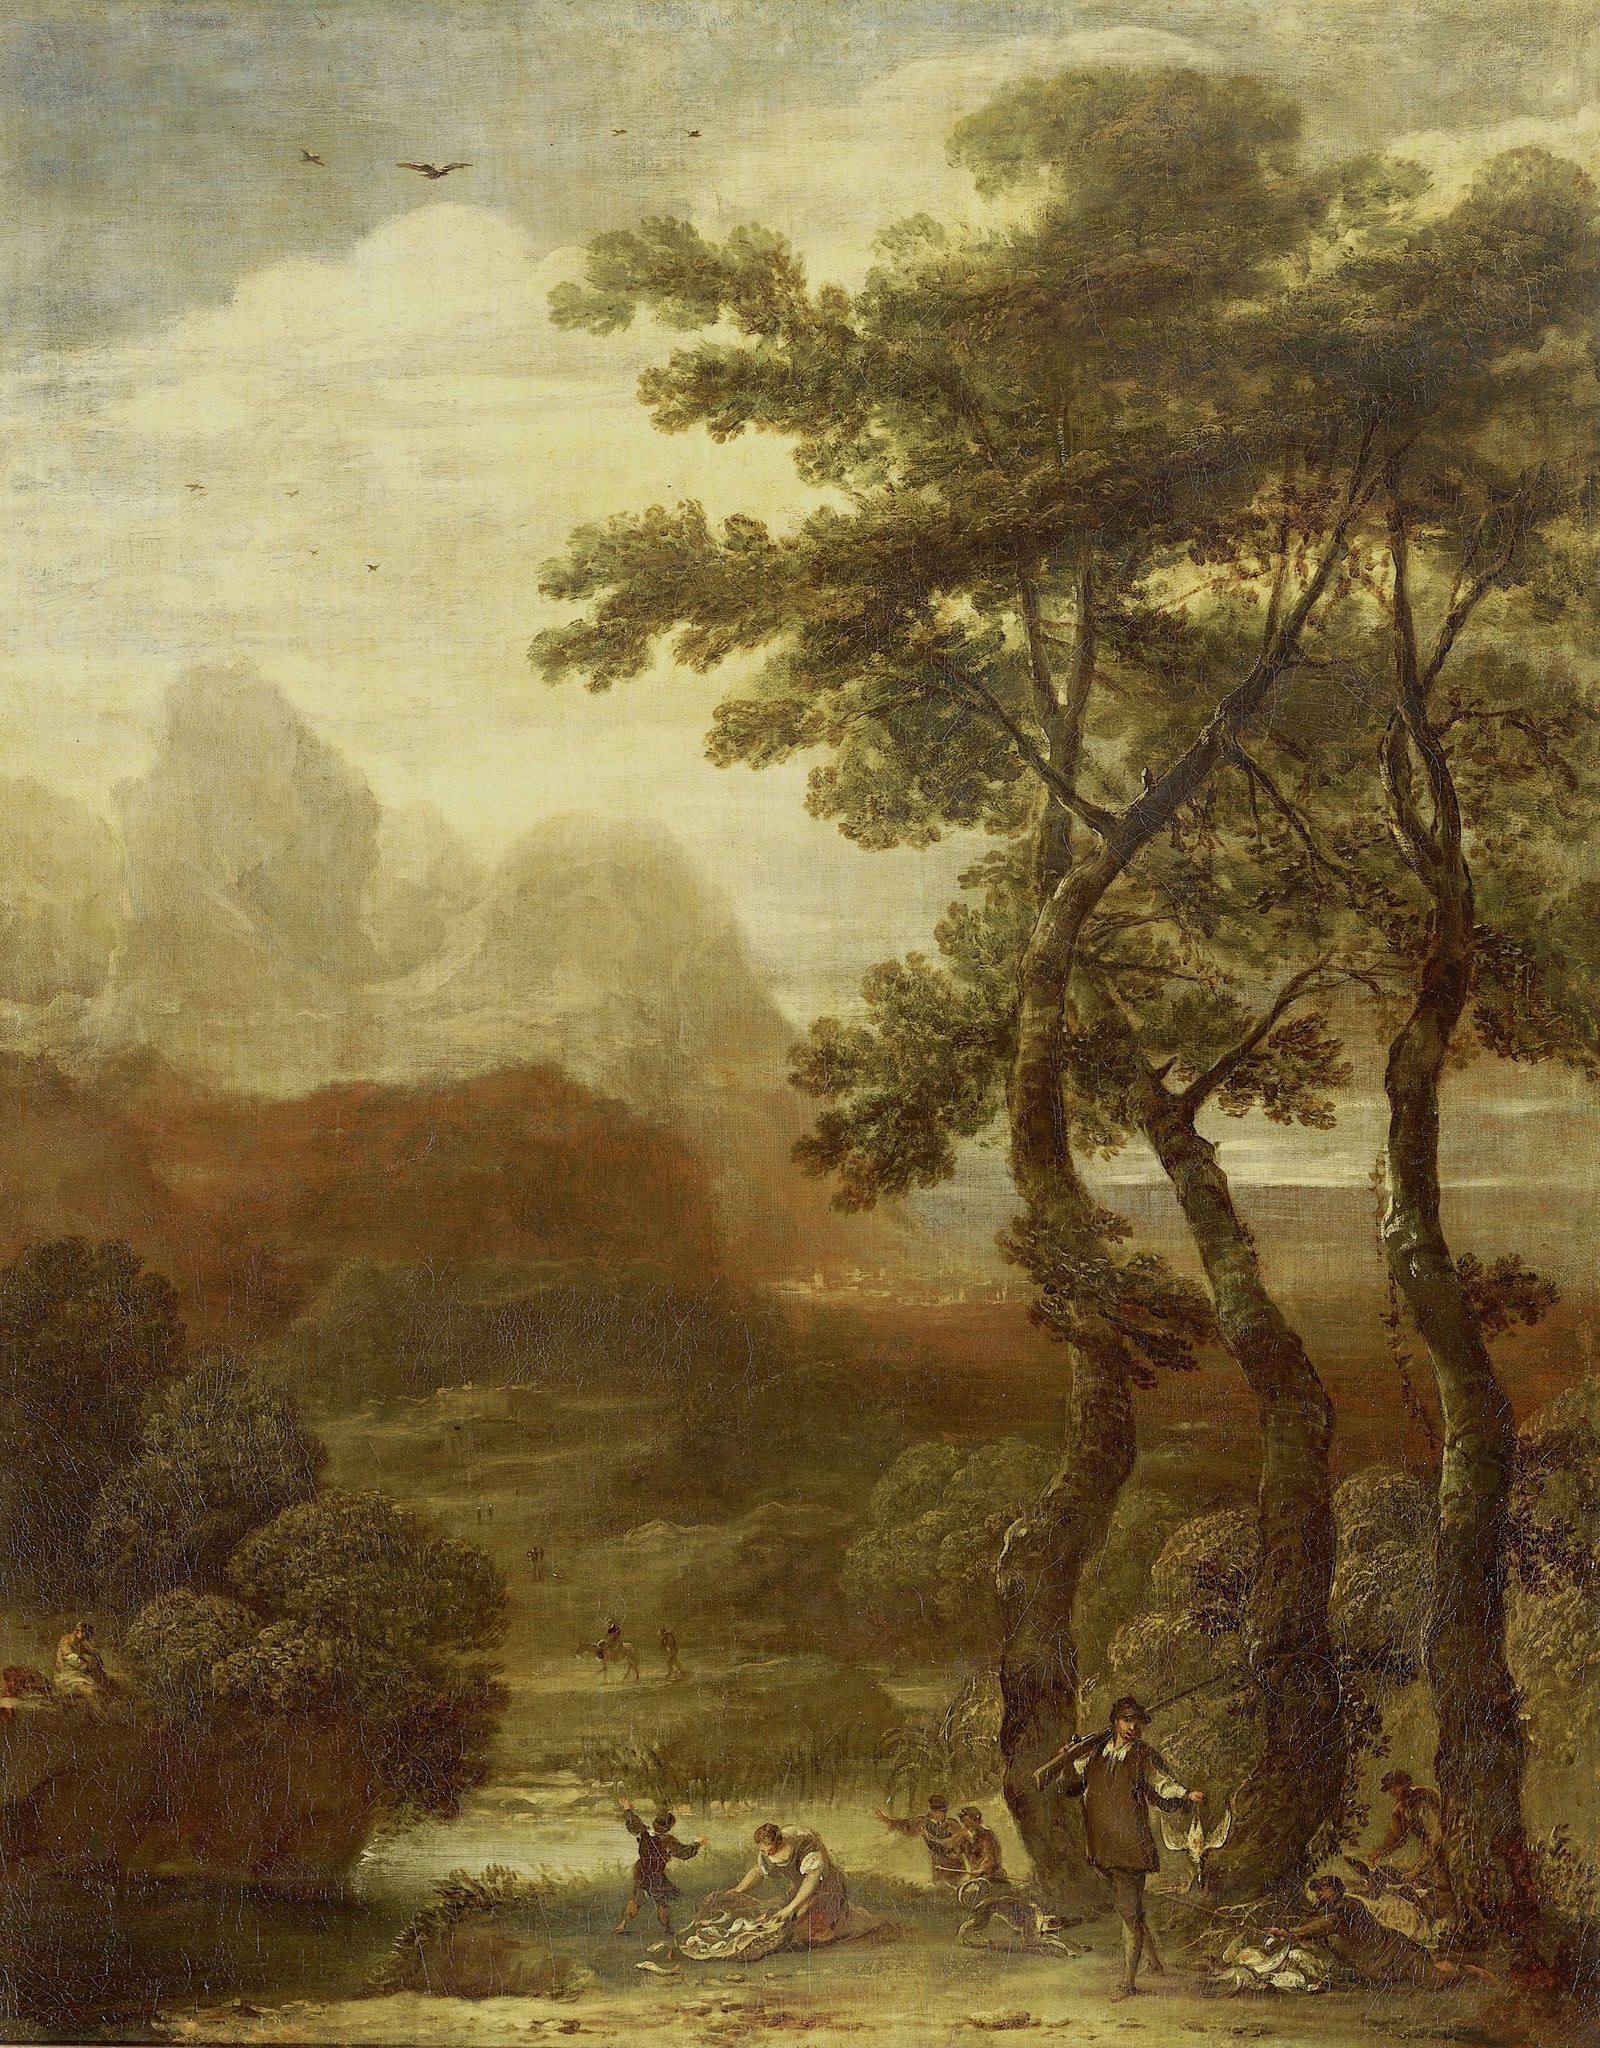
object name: painting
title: Landscape with Hunters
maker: ignacio de iriarte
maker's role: painter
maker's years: 1621-1685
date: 1640-1685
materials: canvas, oil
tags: hunters hunting (n.b.: in 1988-1990 this notation denoted the concept of 43c11421 'hunters resting during the hunt'), mountains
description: Landschap met op de voorgrond jagers onder een groep van drie bomen. In de verte een stad gelegen aan de voet van een gebergte.